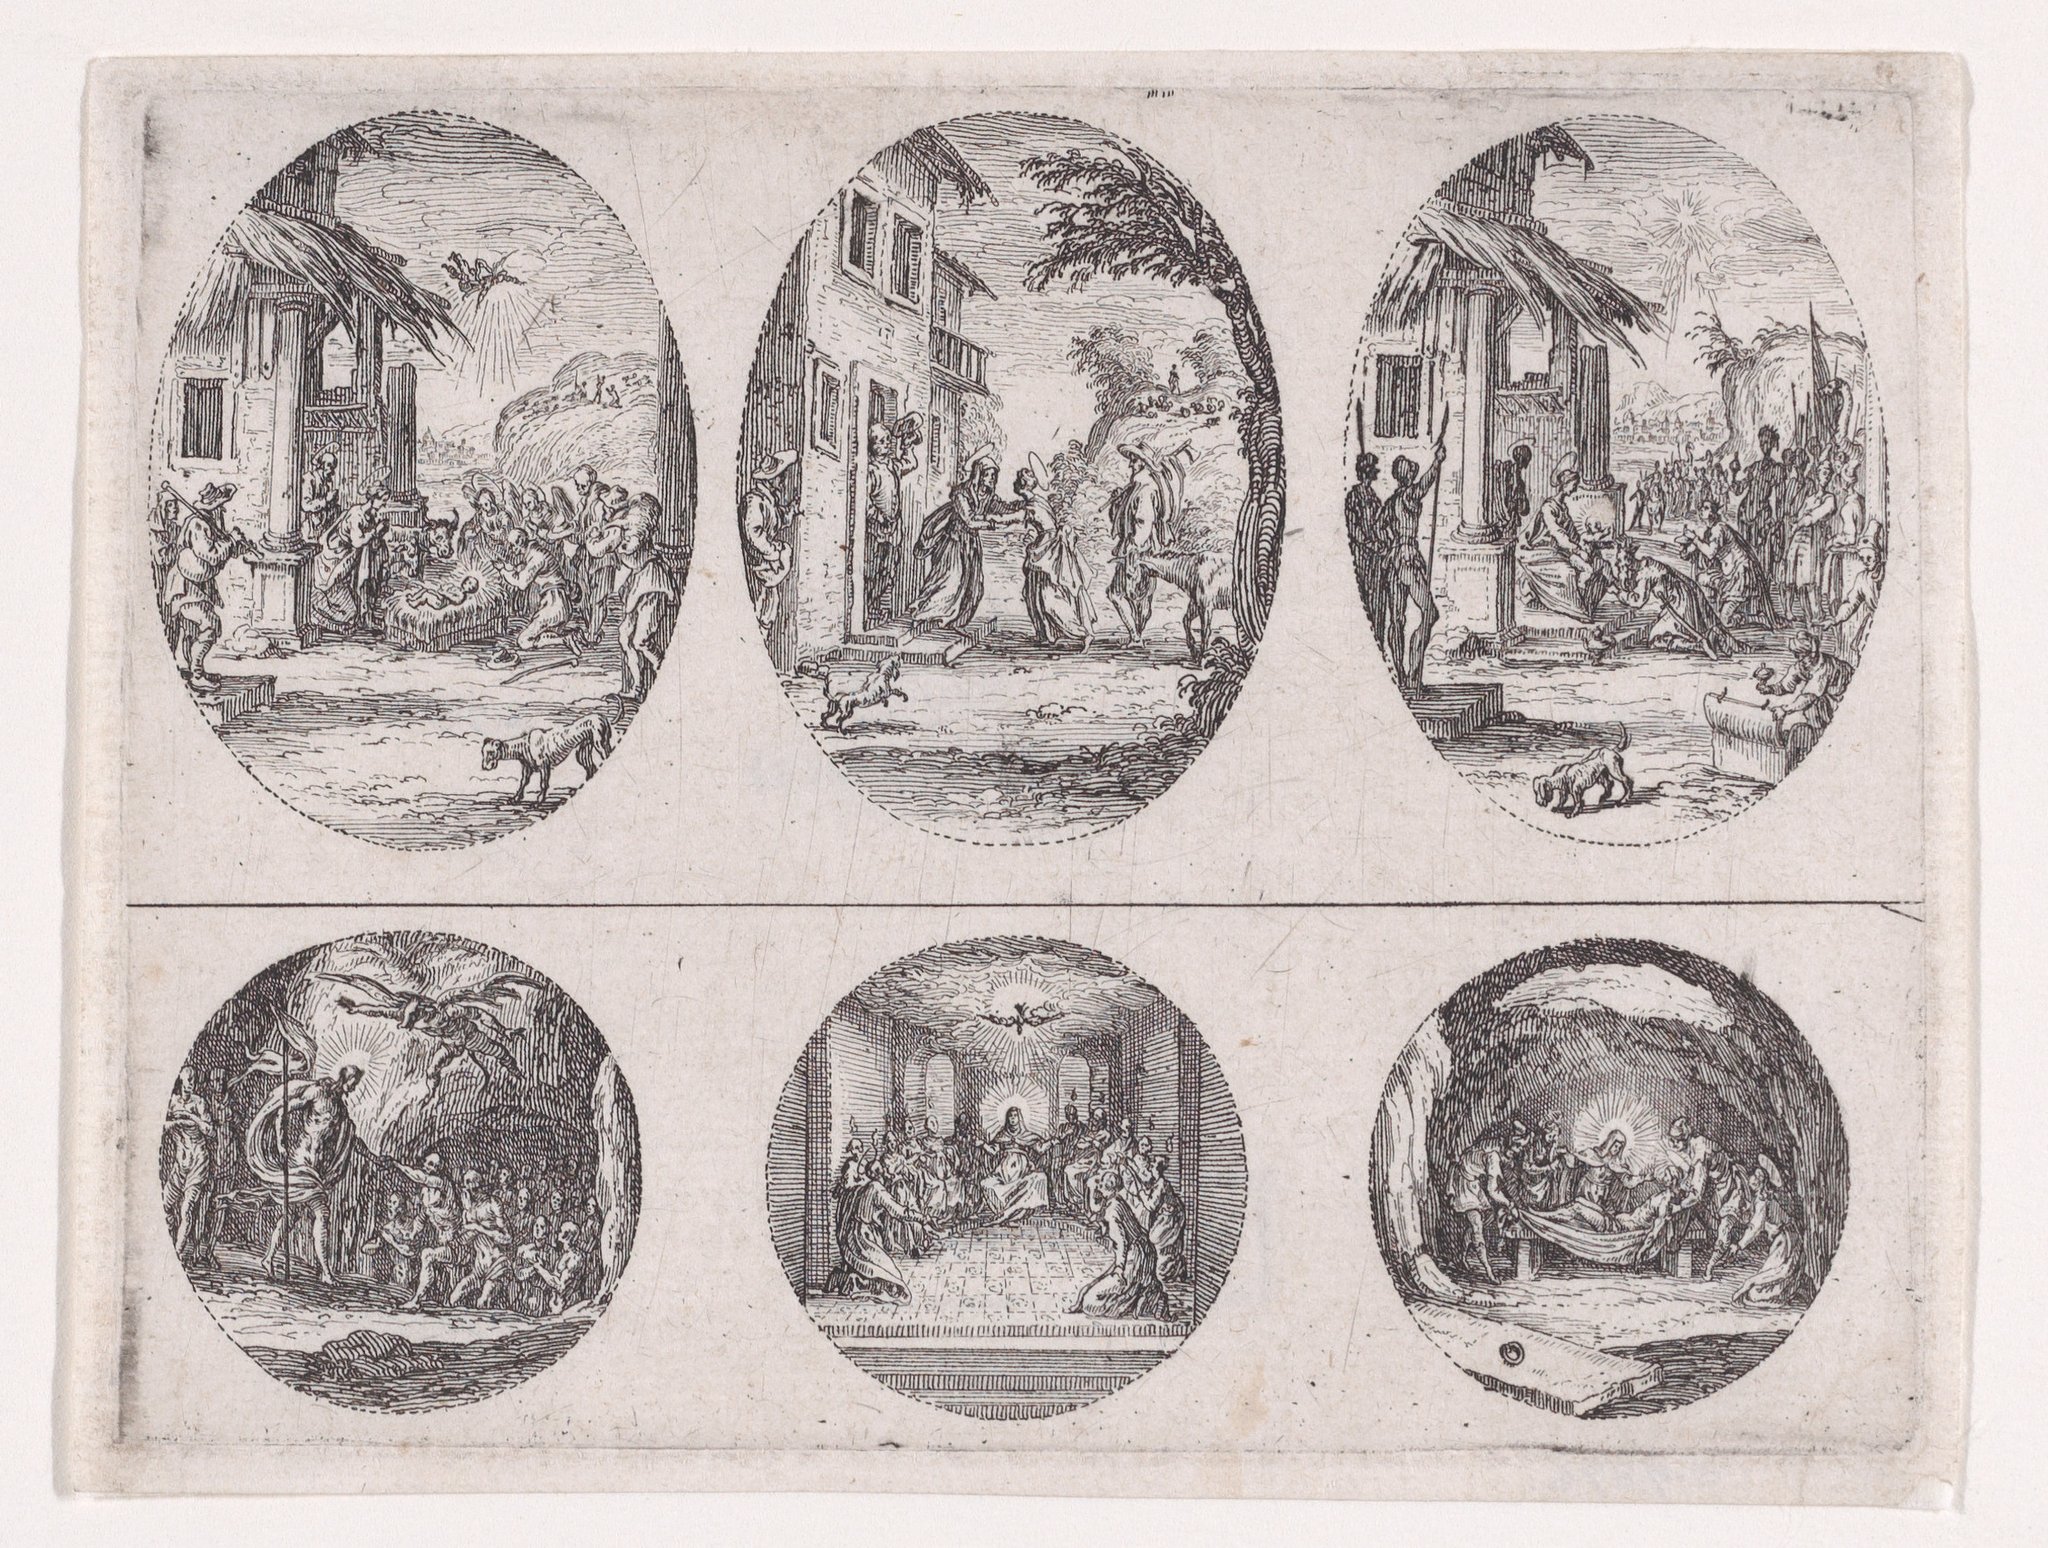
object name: print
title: Two Oval Medallions and Two Rondels, from "Variae tum Passionis Christi tum vitae beatae Mariae Virginis; Les Mystères de la Passion suite appelée aussi Mystères de la Vie de Jésus et Mystères de la Vie de Jésus et de la Vie de la Ste. Vierge" (The Mysteries of the Passion, also called the Mysteries of the Life of Jesus, and the Mysteries of the Life of Jesus and of the Virgin)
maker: jacques callot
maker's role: artist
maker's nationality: french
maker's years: 1592-1635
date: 1631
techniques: engraving, etching